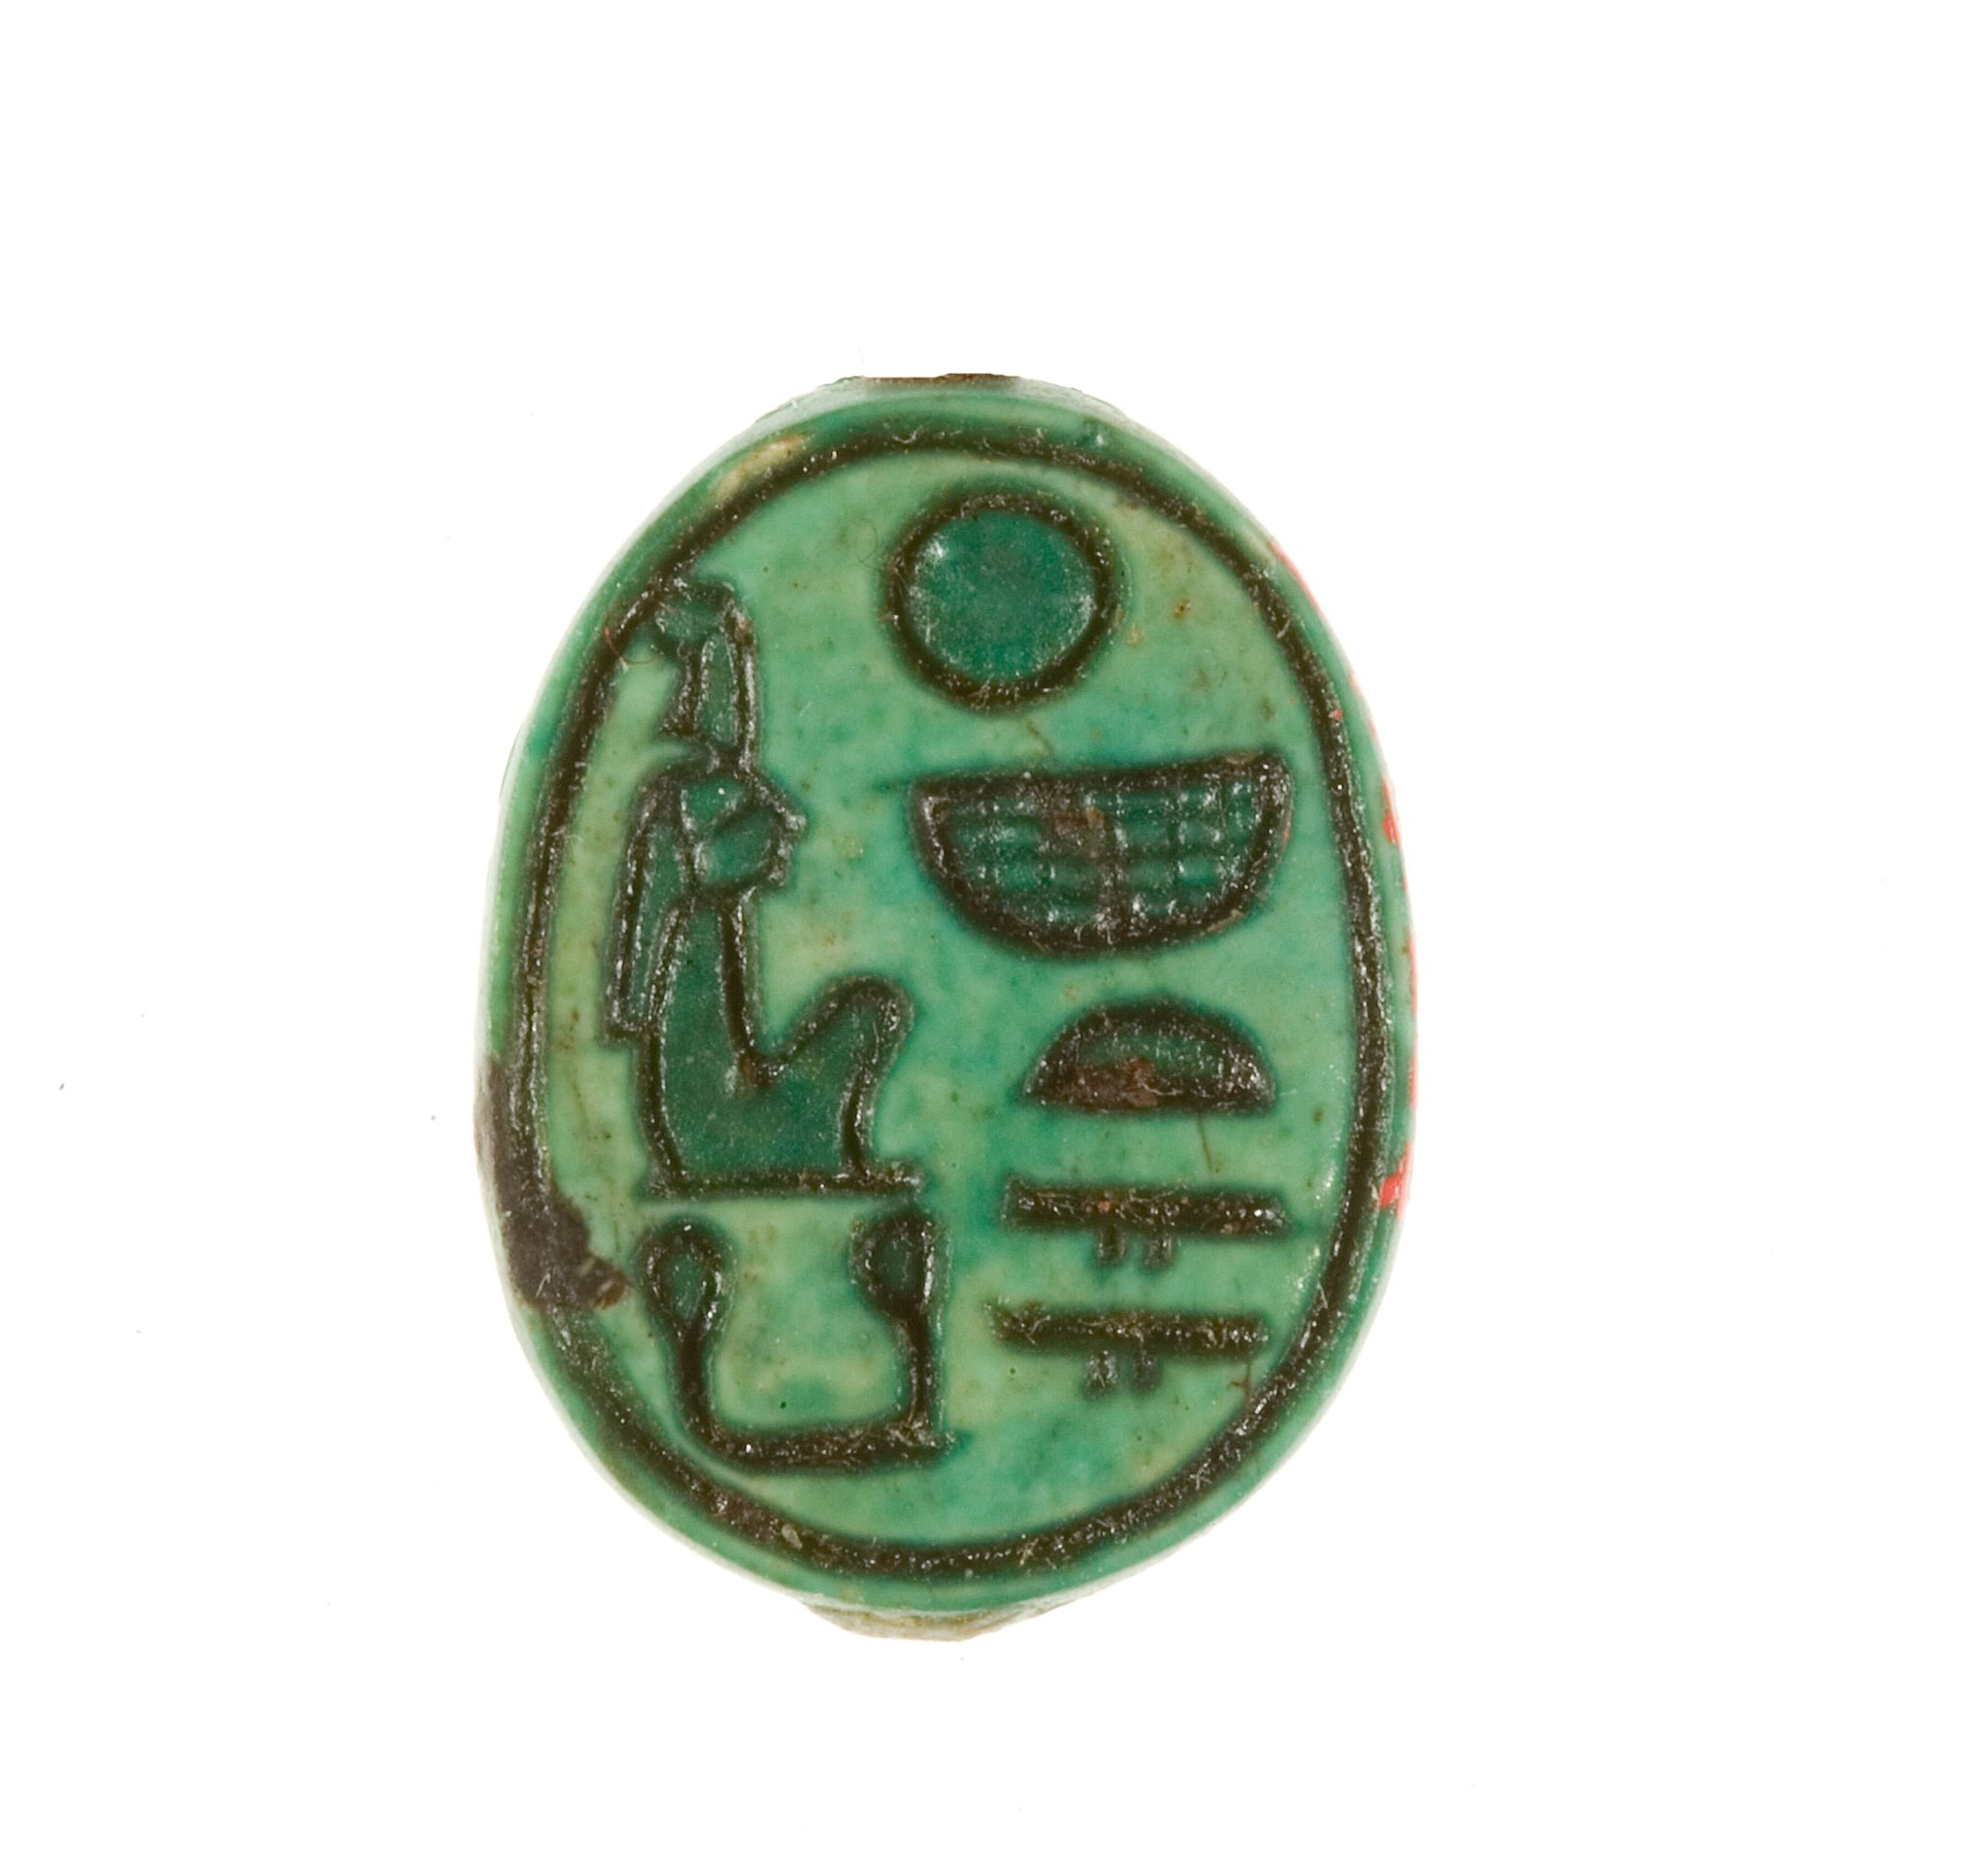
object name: scarab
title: Scarab Inscribed Lady of the Two Lands Maatkare (Hatshepsut)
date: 1479-1458 BCE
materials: stone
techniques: glazing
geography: egypt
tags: women